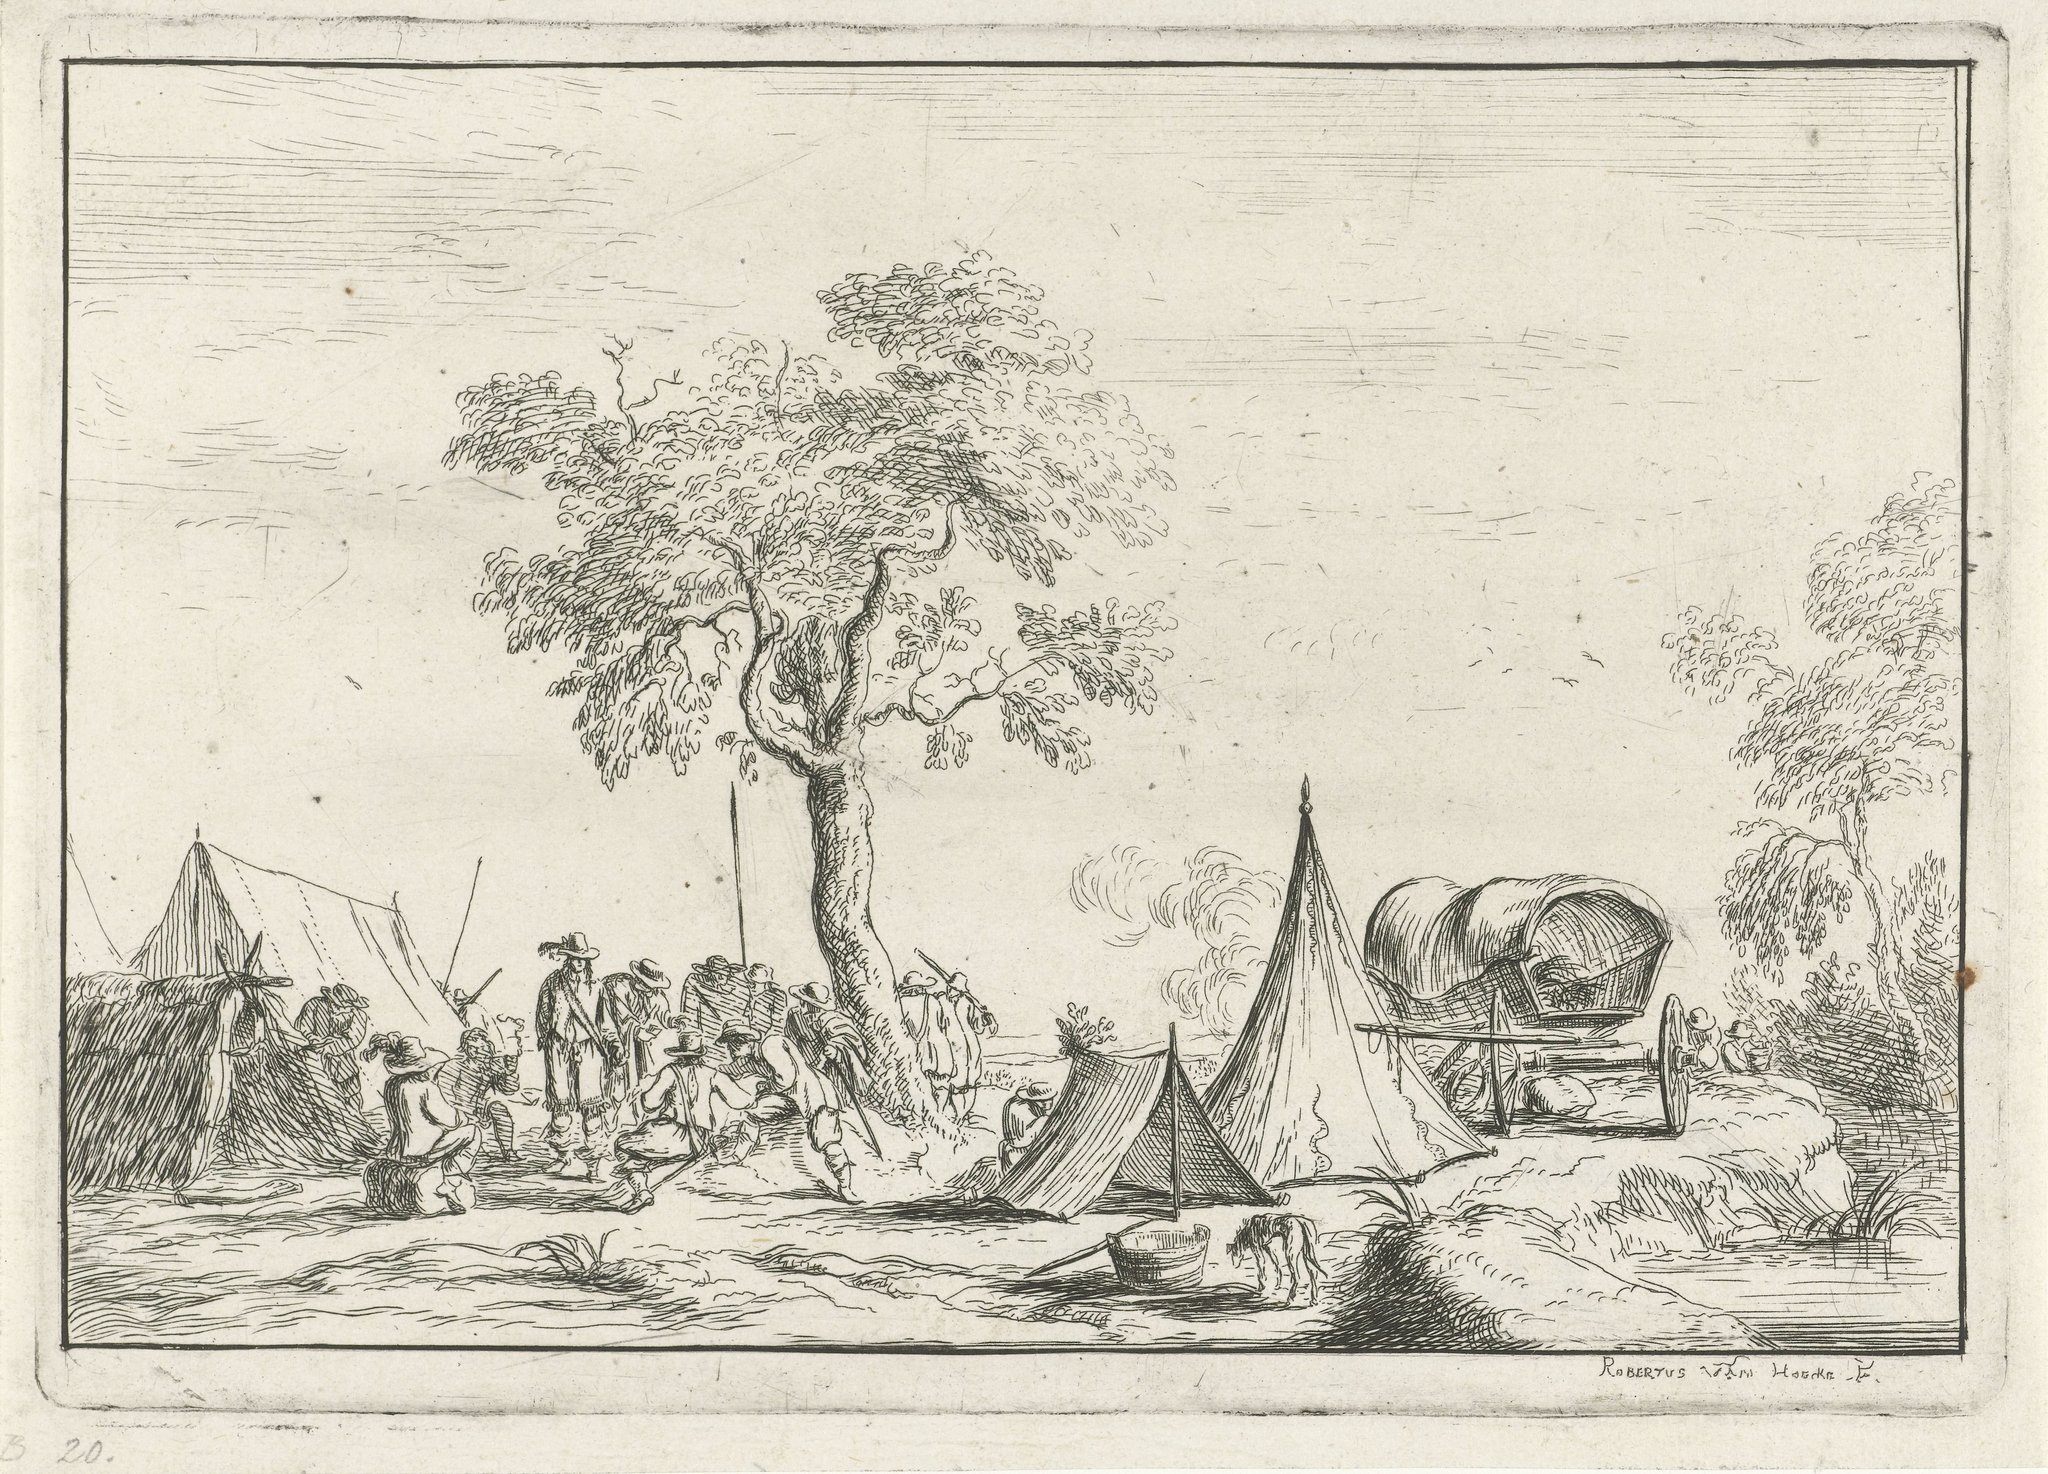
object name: print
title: Kampement met een spitse tent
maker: robert van den hoecke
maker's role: draughtsman, painter, print maker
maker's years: 1622-1668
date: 1632-1668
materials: paper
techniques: etching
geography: southern netherlands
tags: tent, covered wagon, hooded wagon, tent-camp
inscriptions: collector's mark: Lugt 2228